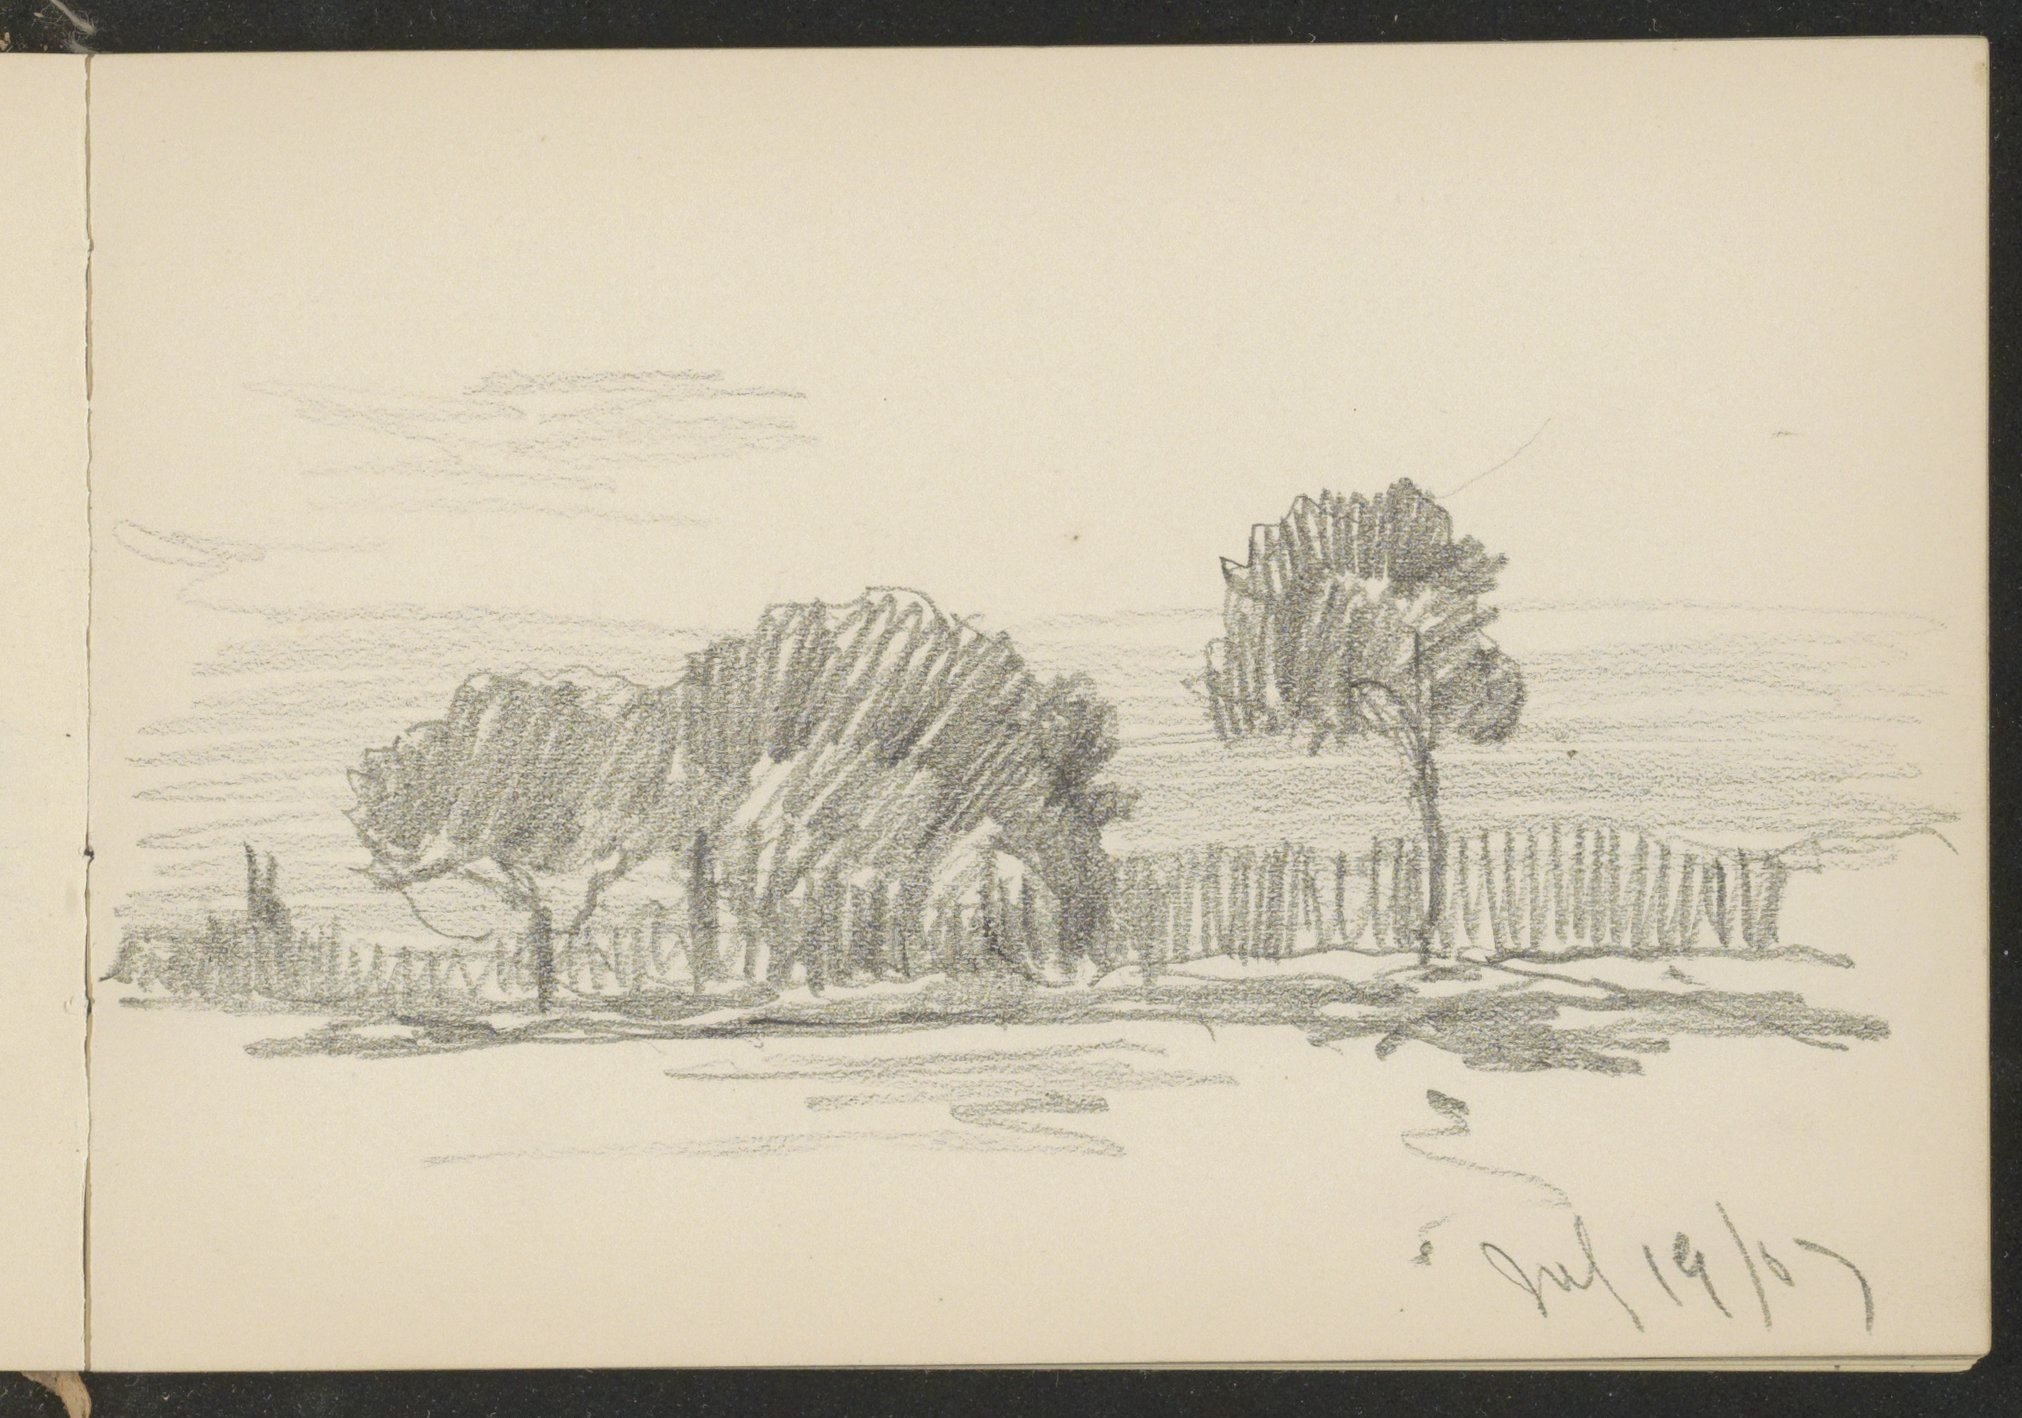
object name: sketchbook leaf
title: Landschap met bomen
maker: alexander shilling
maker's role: draughtsman, print maker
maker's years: 1859-1937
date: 1907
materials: paper, pencil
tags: trees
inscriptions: date: ‘Jul 19/07’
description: Blad 6 recto uit een schetsboek met 24 bladen.